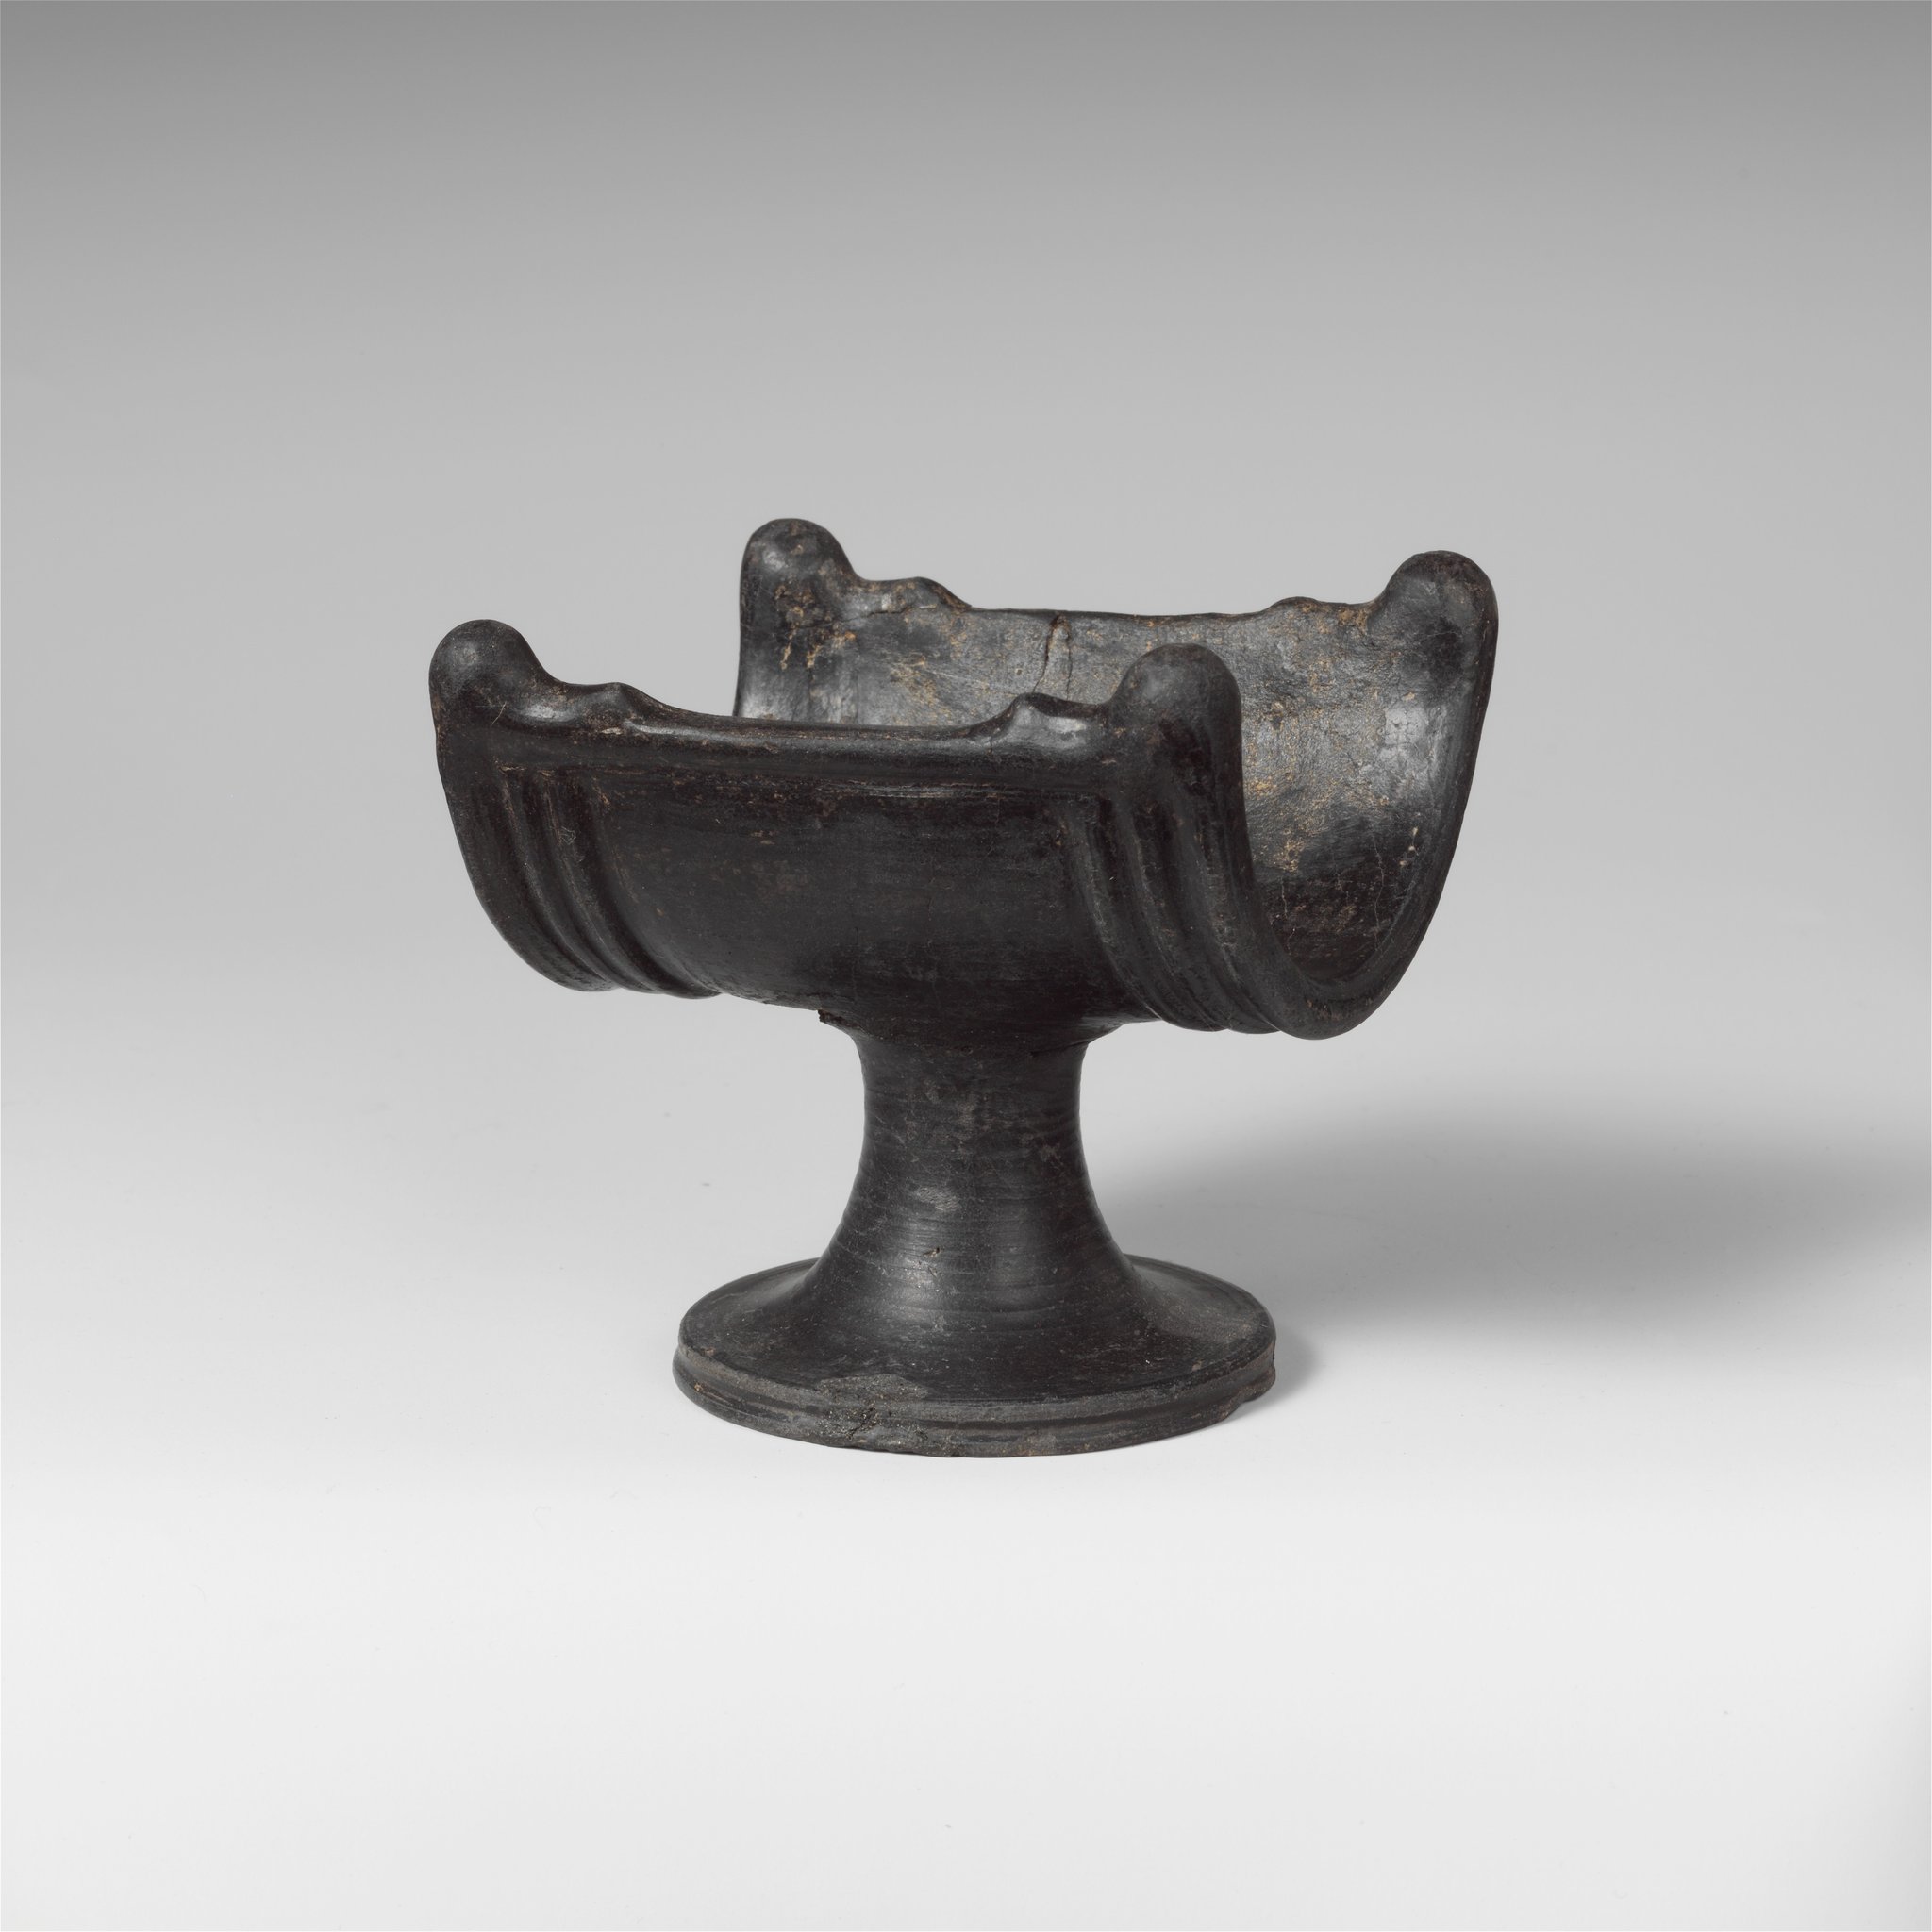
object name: stand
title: Terracotta stand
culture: etruscan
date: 600-501 BCE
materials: terracotta